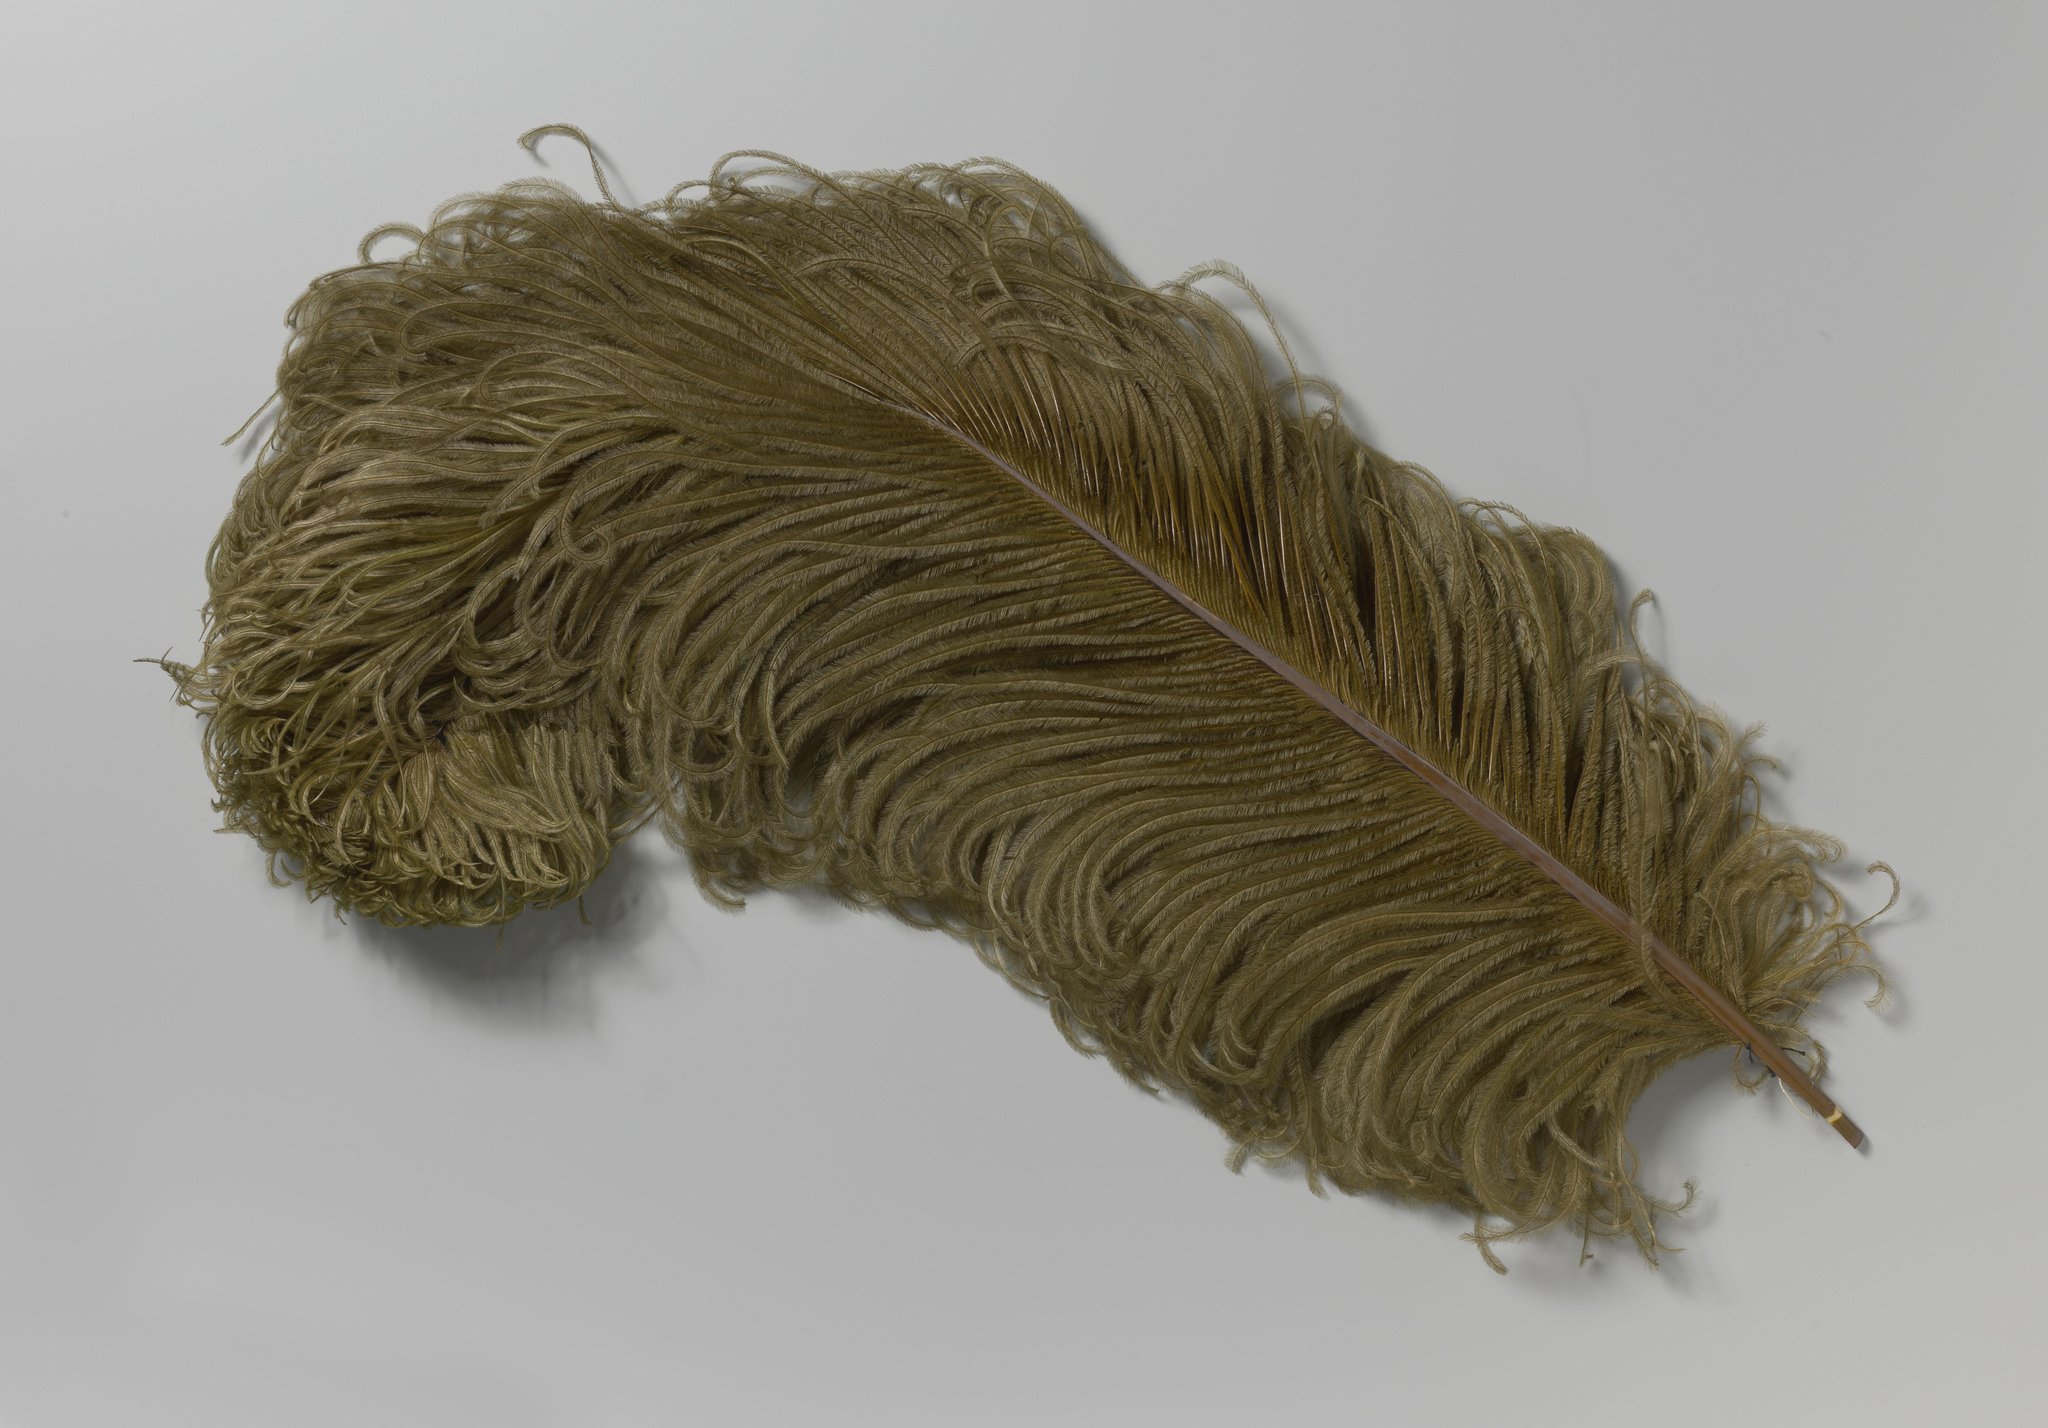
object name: hoedengarneersel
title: Struisveer, mosgroen van kleur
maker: Anonymous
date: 1895-1915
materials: ostrich feather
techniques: painting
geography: western europe